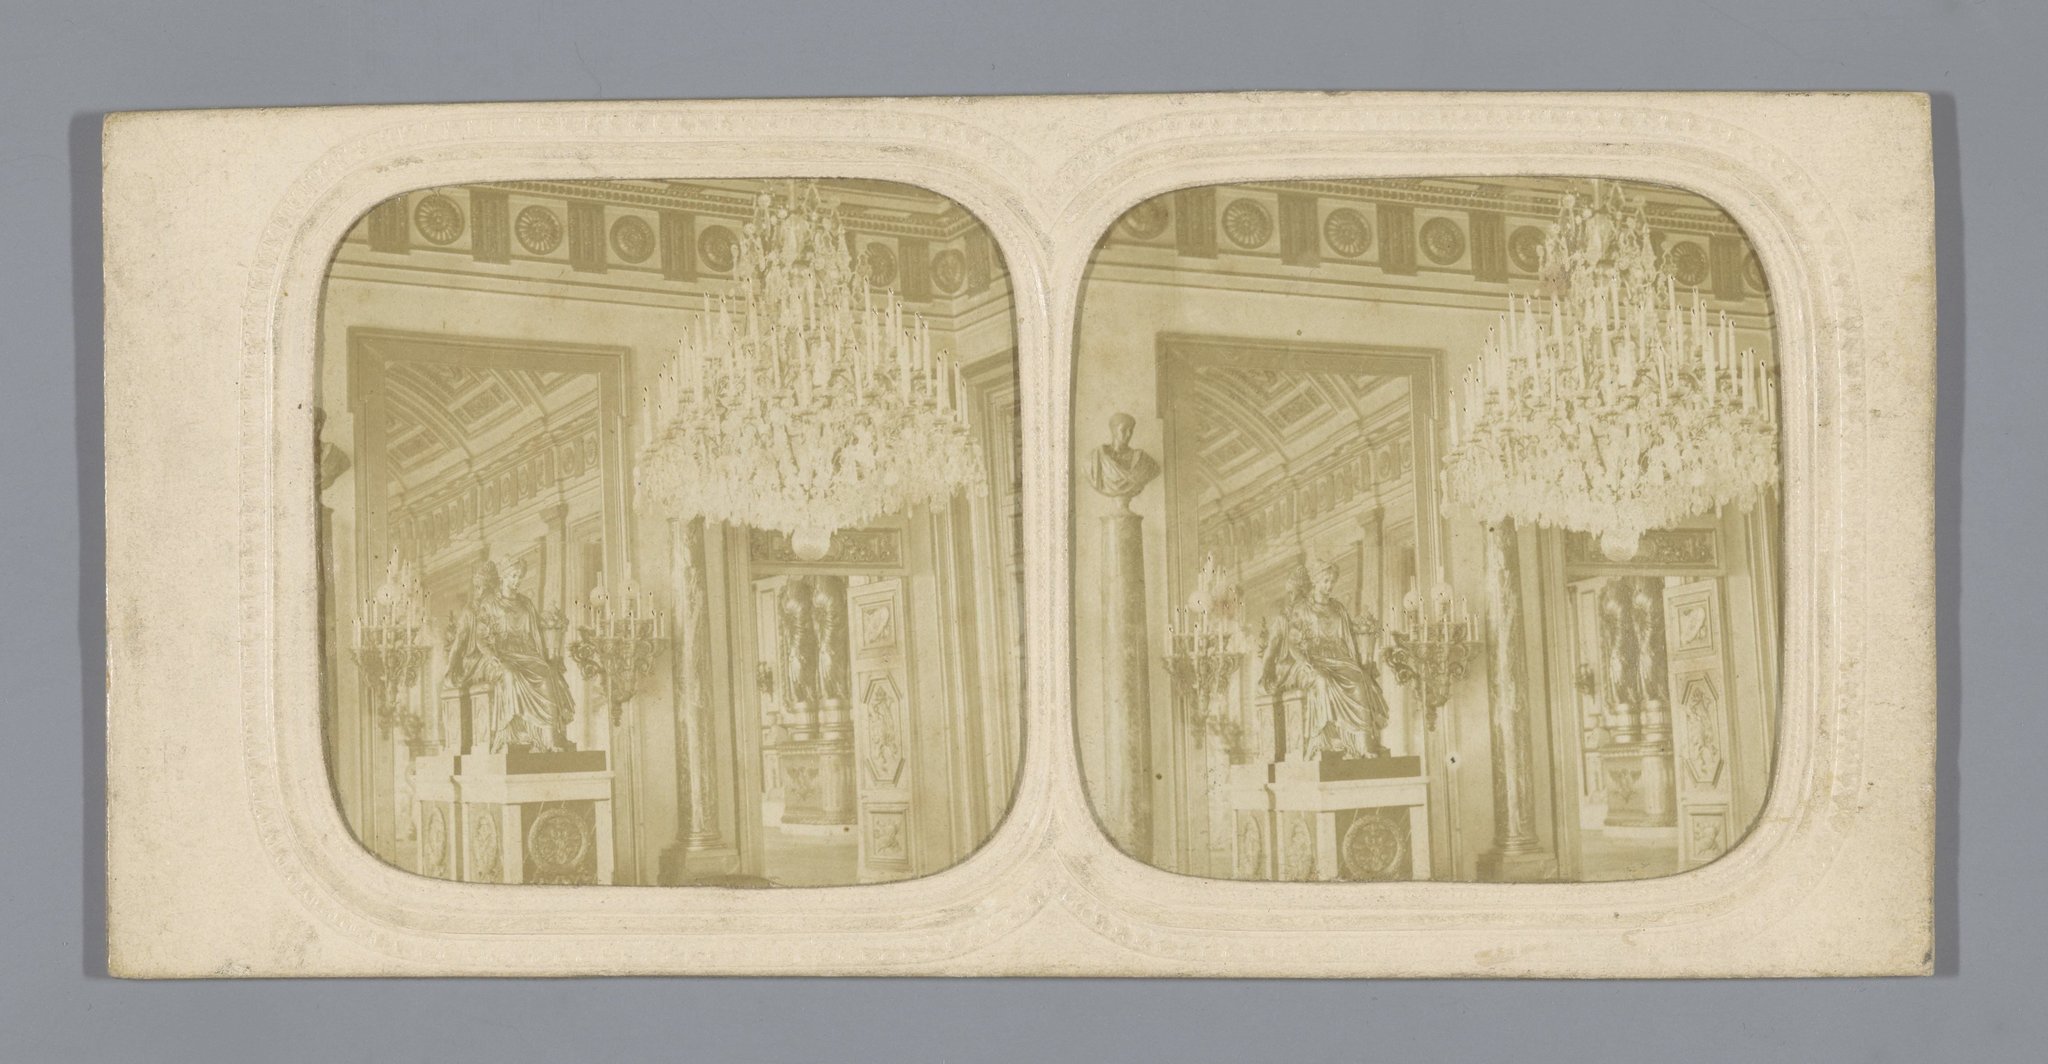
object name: tissue stereograph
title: Allegorisch beeld van de vrede in de Salon de la Paix in het Tuilerieënpaleis, Parijs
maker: Anonymous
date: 1855-1871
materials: cardboard, paper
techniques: albumen print, hand coloring, perforating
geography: paris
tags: palace - aa - civic architecture: inside, symbols, allegories of peace, 'pax'; 'pace' (ripa), tuileries palace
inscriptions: number: ‘6’